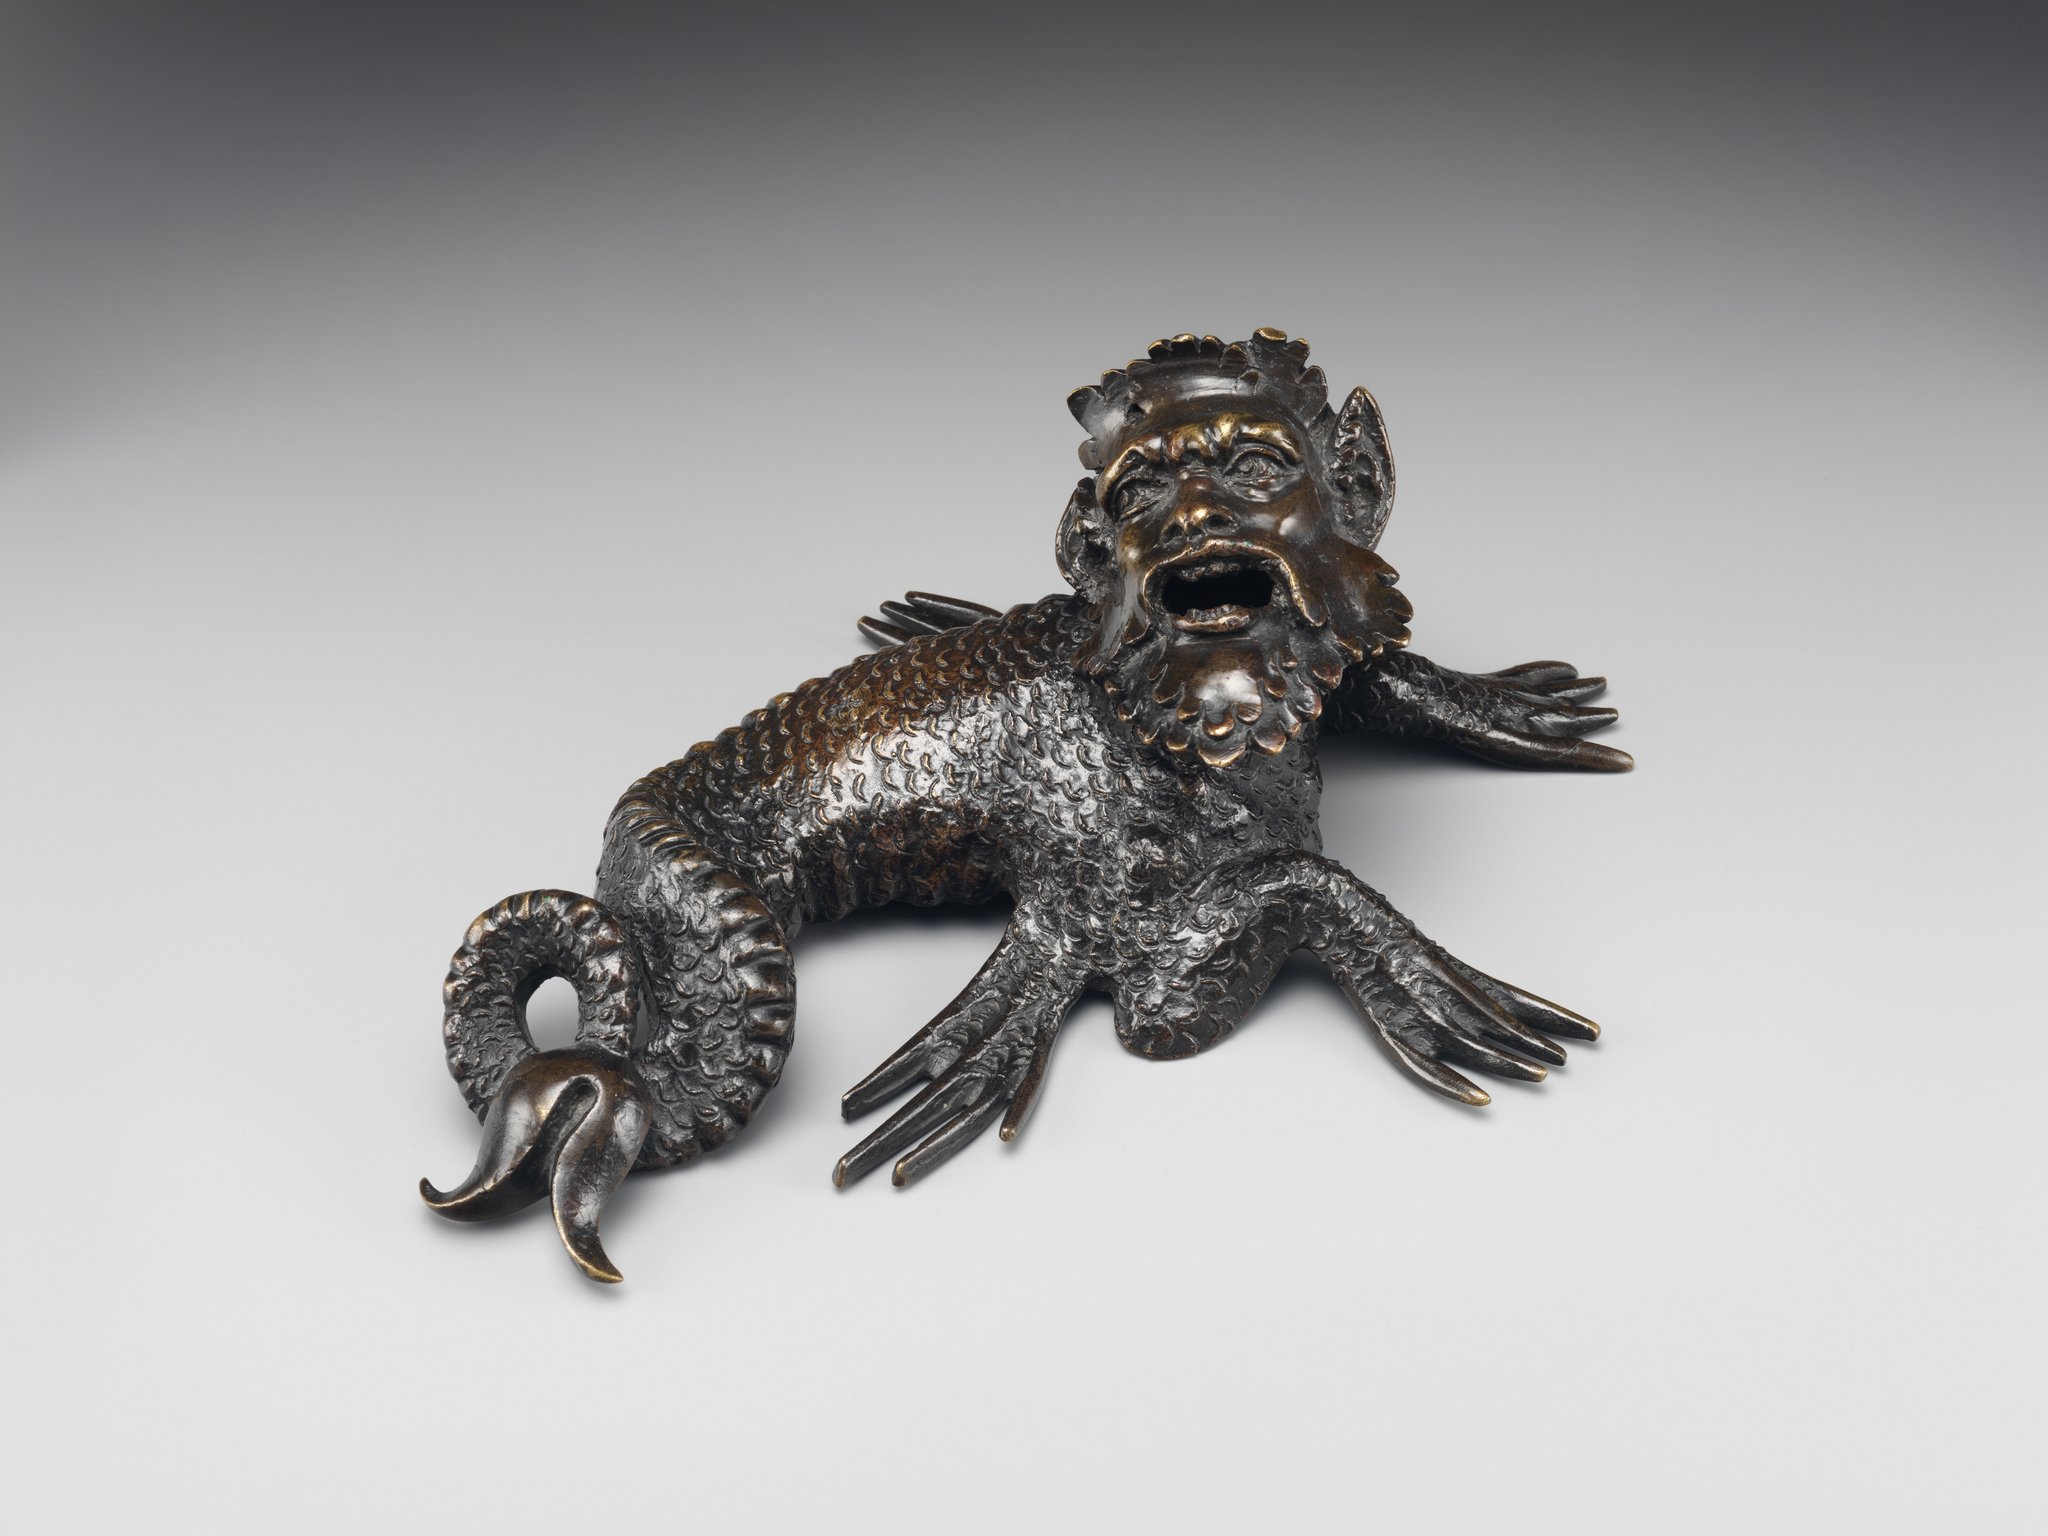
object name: statuette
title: Sea monster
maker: severo calzetta da ravenna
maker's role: artist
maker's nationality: italian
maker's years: 1496-1543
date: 1500-1510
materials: bronze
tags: monsters